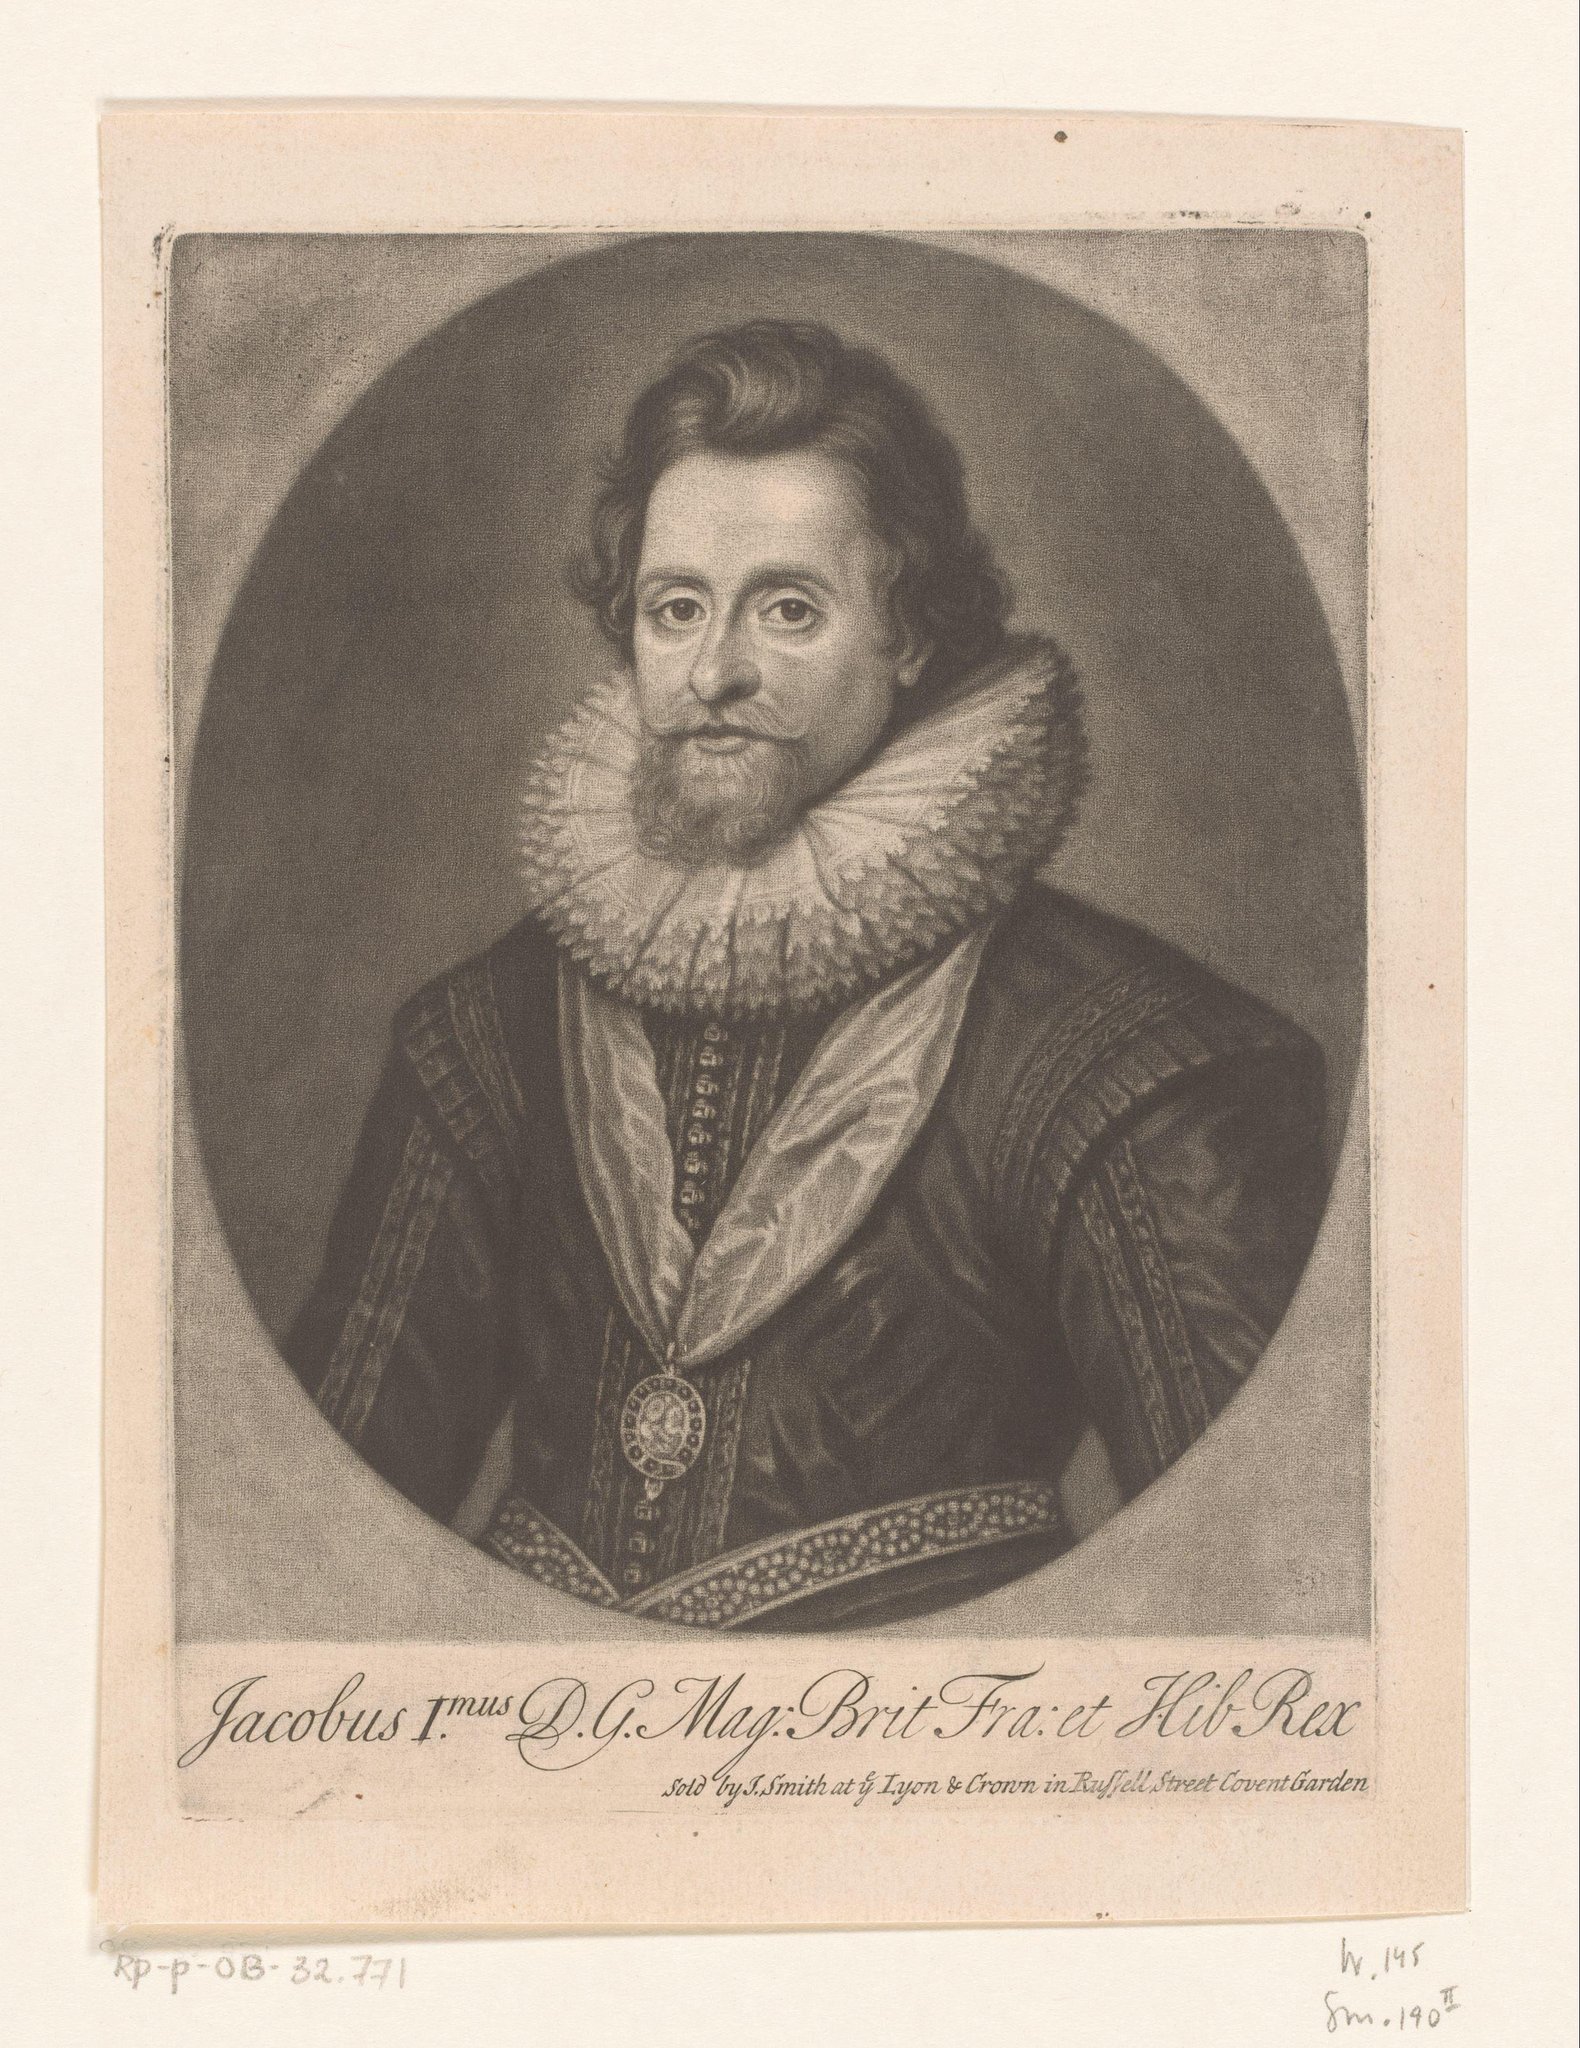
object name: print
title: Portret van Jacobus I, koning van Engeland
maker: john smith (prentmaker/ uitgever)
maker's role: print maker, publisher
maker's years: 1652-1743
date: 1662-1742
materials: paper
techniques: mezzotint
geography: london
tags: jacobus i (koning van engeland), historical persons, king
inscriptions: collector's mark: Lugt 240